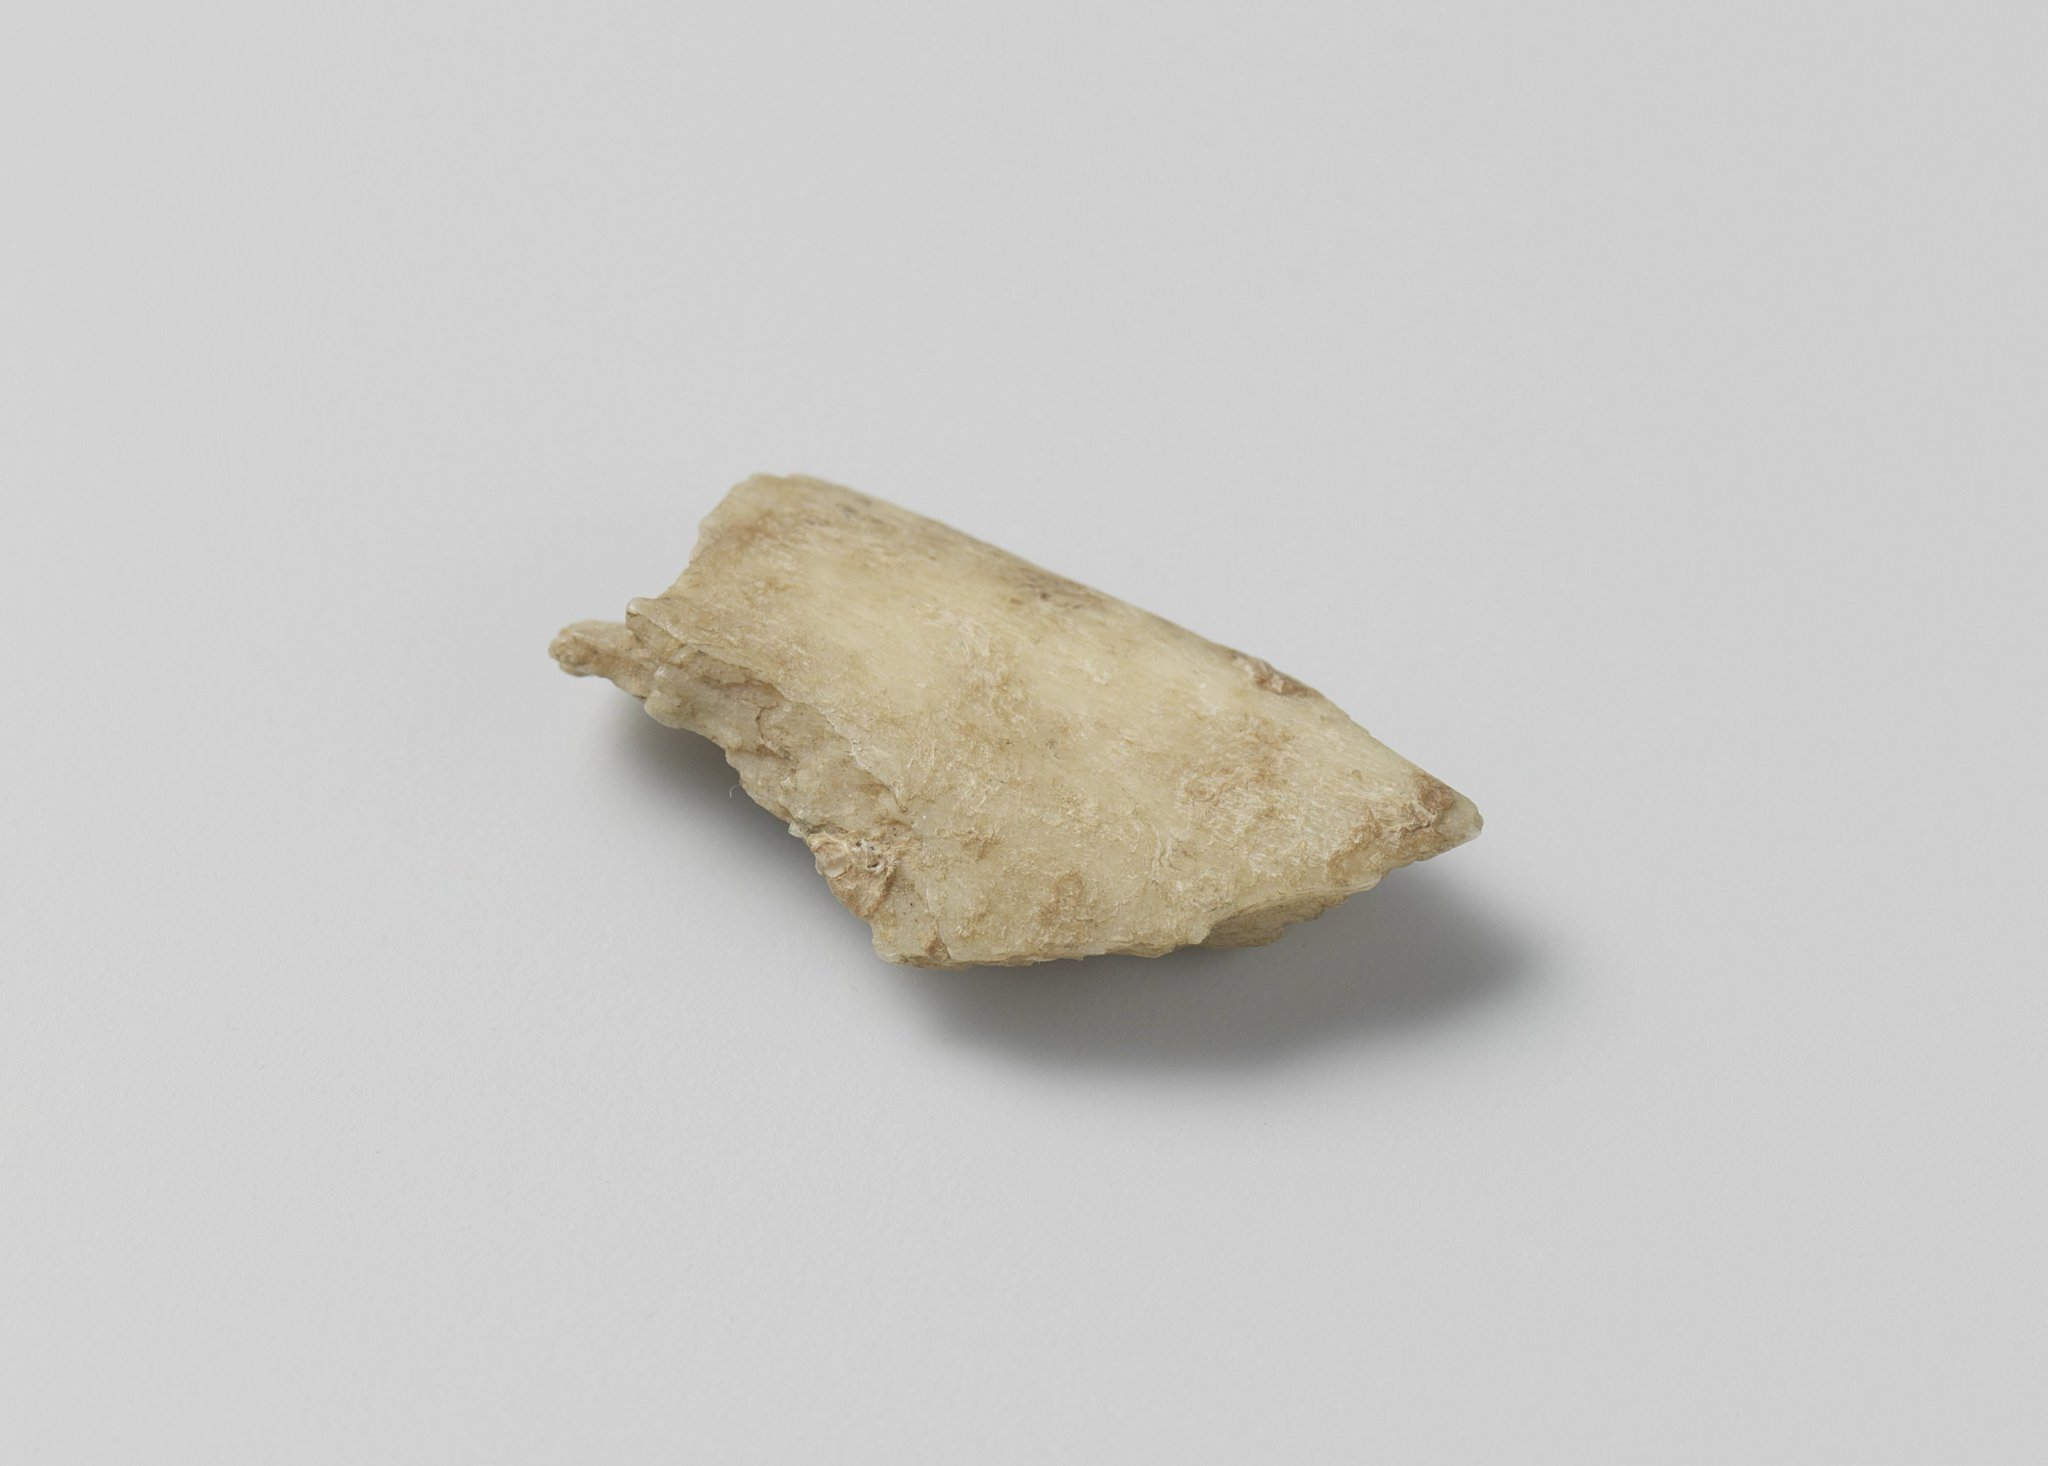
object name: bone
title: Two Pieces of Bone from the Wound in Henry Casimir I’s Hip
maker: niet van toepassing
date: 1612-1640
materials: bone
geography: netherlands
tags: hendrik casimir i graaf van nassau-dietz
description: Hendrik Casimir I (1612-1640), stadhouder van Friesland, werd tijdens de Slag bij Hulst dodelijk in zijn onderrug getroffen. Dit stukje bot zou volgens overlevering zijn verwijderd uit de wond in zjin heup, samen met de kogel. Kogel en stukjes bot werden hierna in de stadhouderlijke verzameling bewaard.